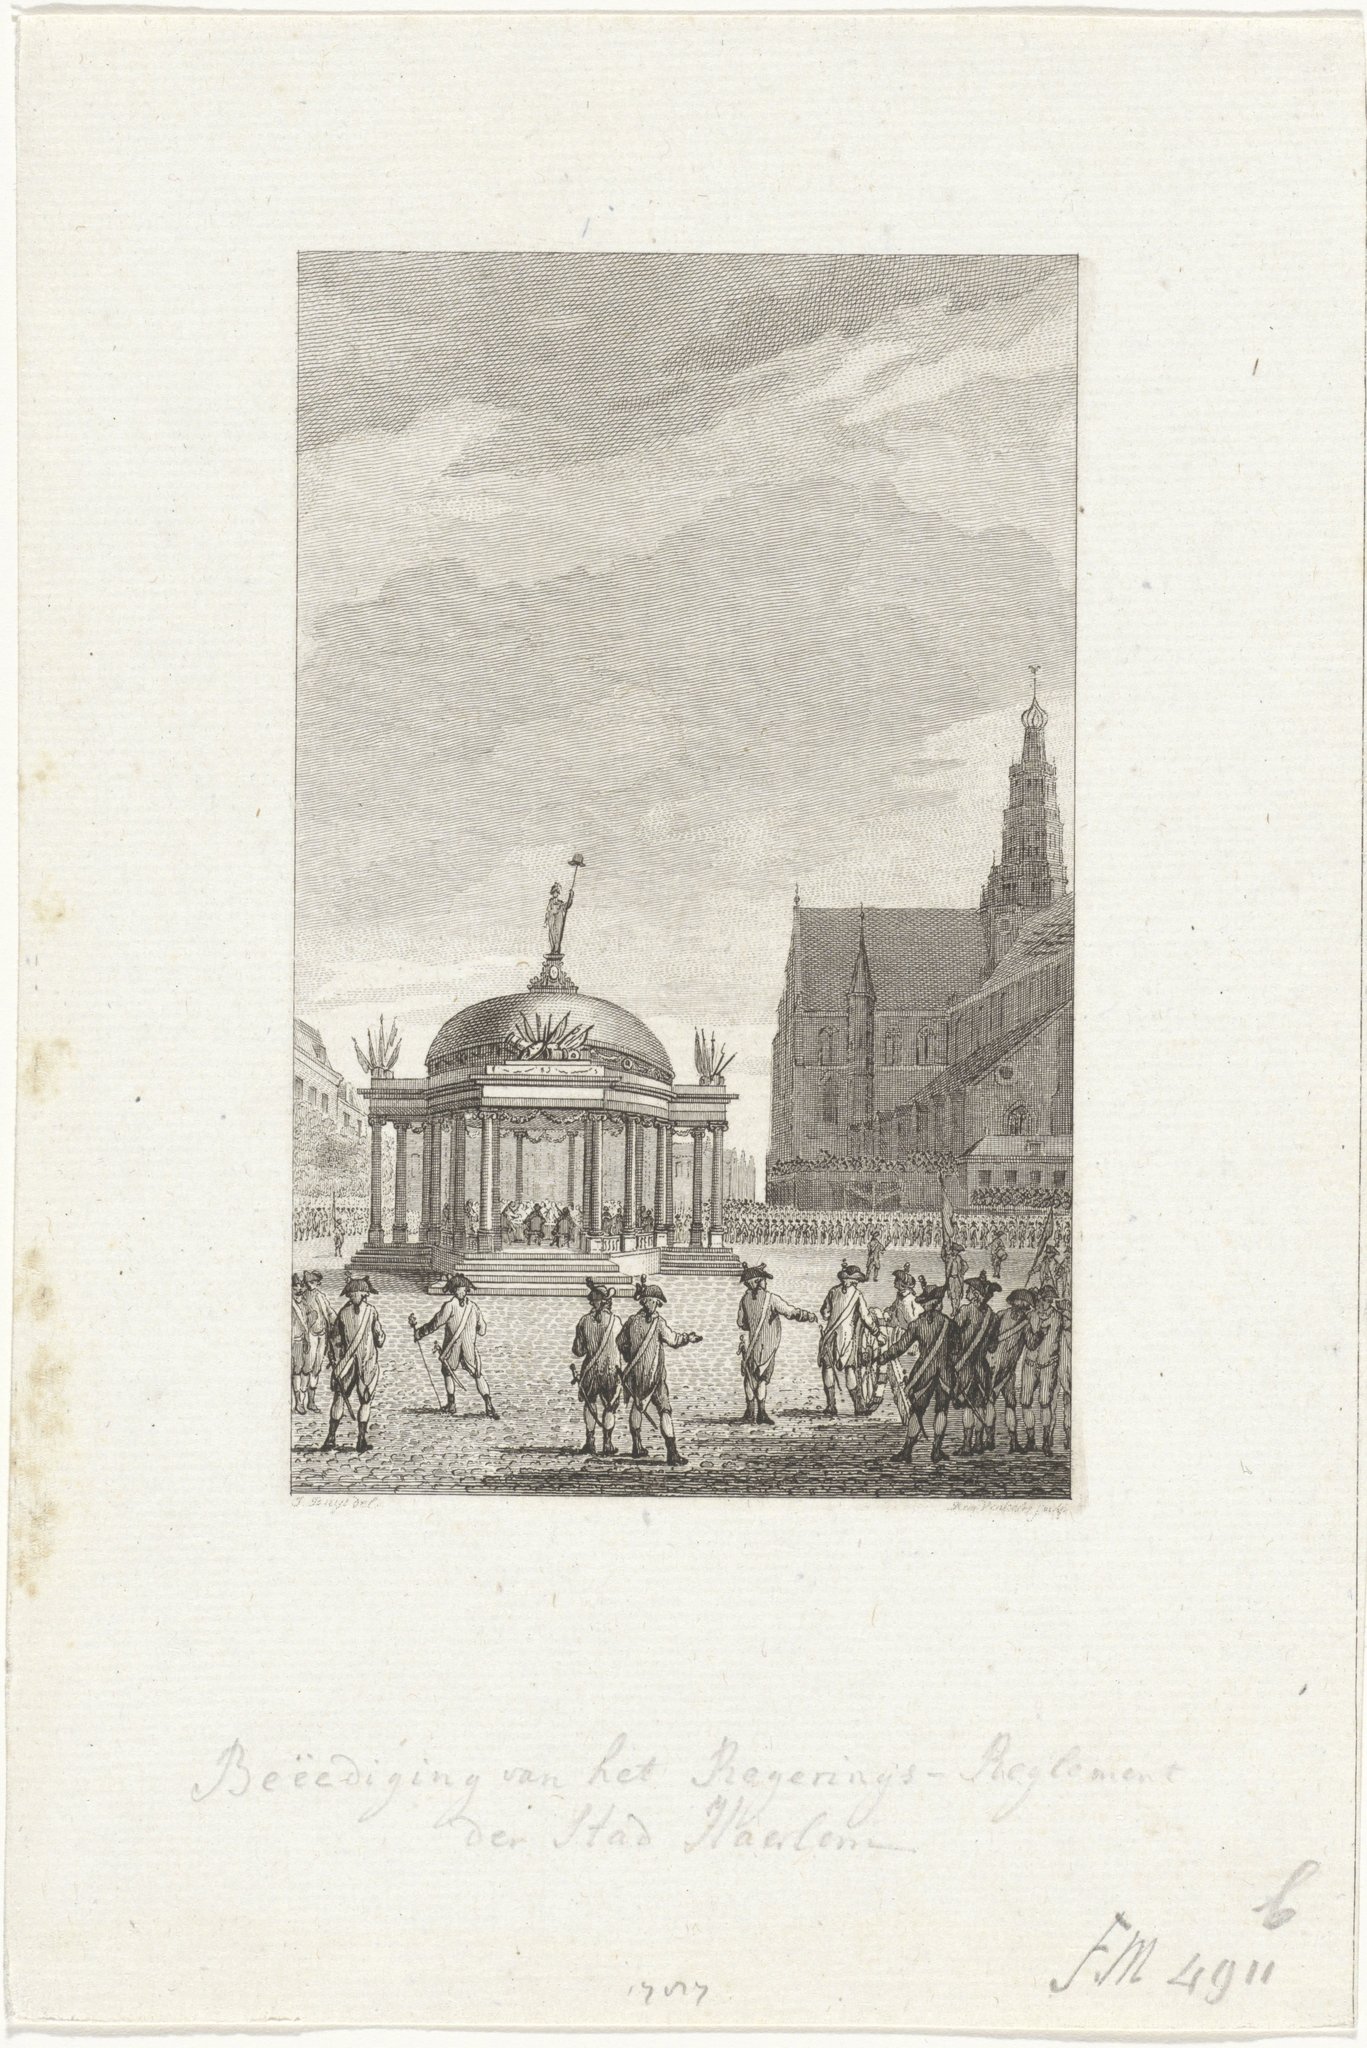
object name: print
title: Beëdiging van het regeringsreglement in Haarlem, 1787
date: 1795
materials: paper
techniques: engraving, etching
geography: amsterdam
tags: proclamation of new government, warfare; military affairs (+ citizen soldiery, civil guard, citizen militia), patriots (1780-1795)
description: Gebruikt als illustratie in: P.A. Loosjes. Vaderlandsche historie, vervattende de geschiedenissen, der Vereenigde Nederlanden (...). Ten onmiddelyken vervolge van Wagenaar's Vaderlandsche historie. Amsterdam: Johannes Allart, dl. 15.